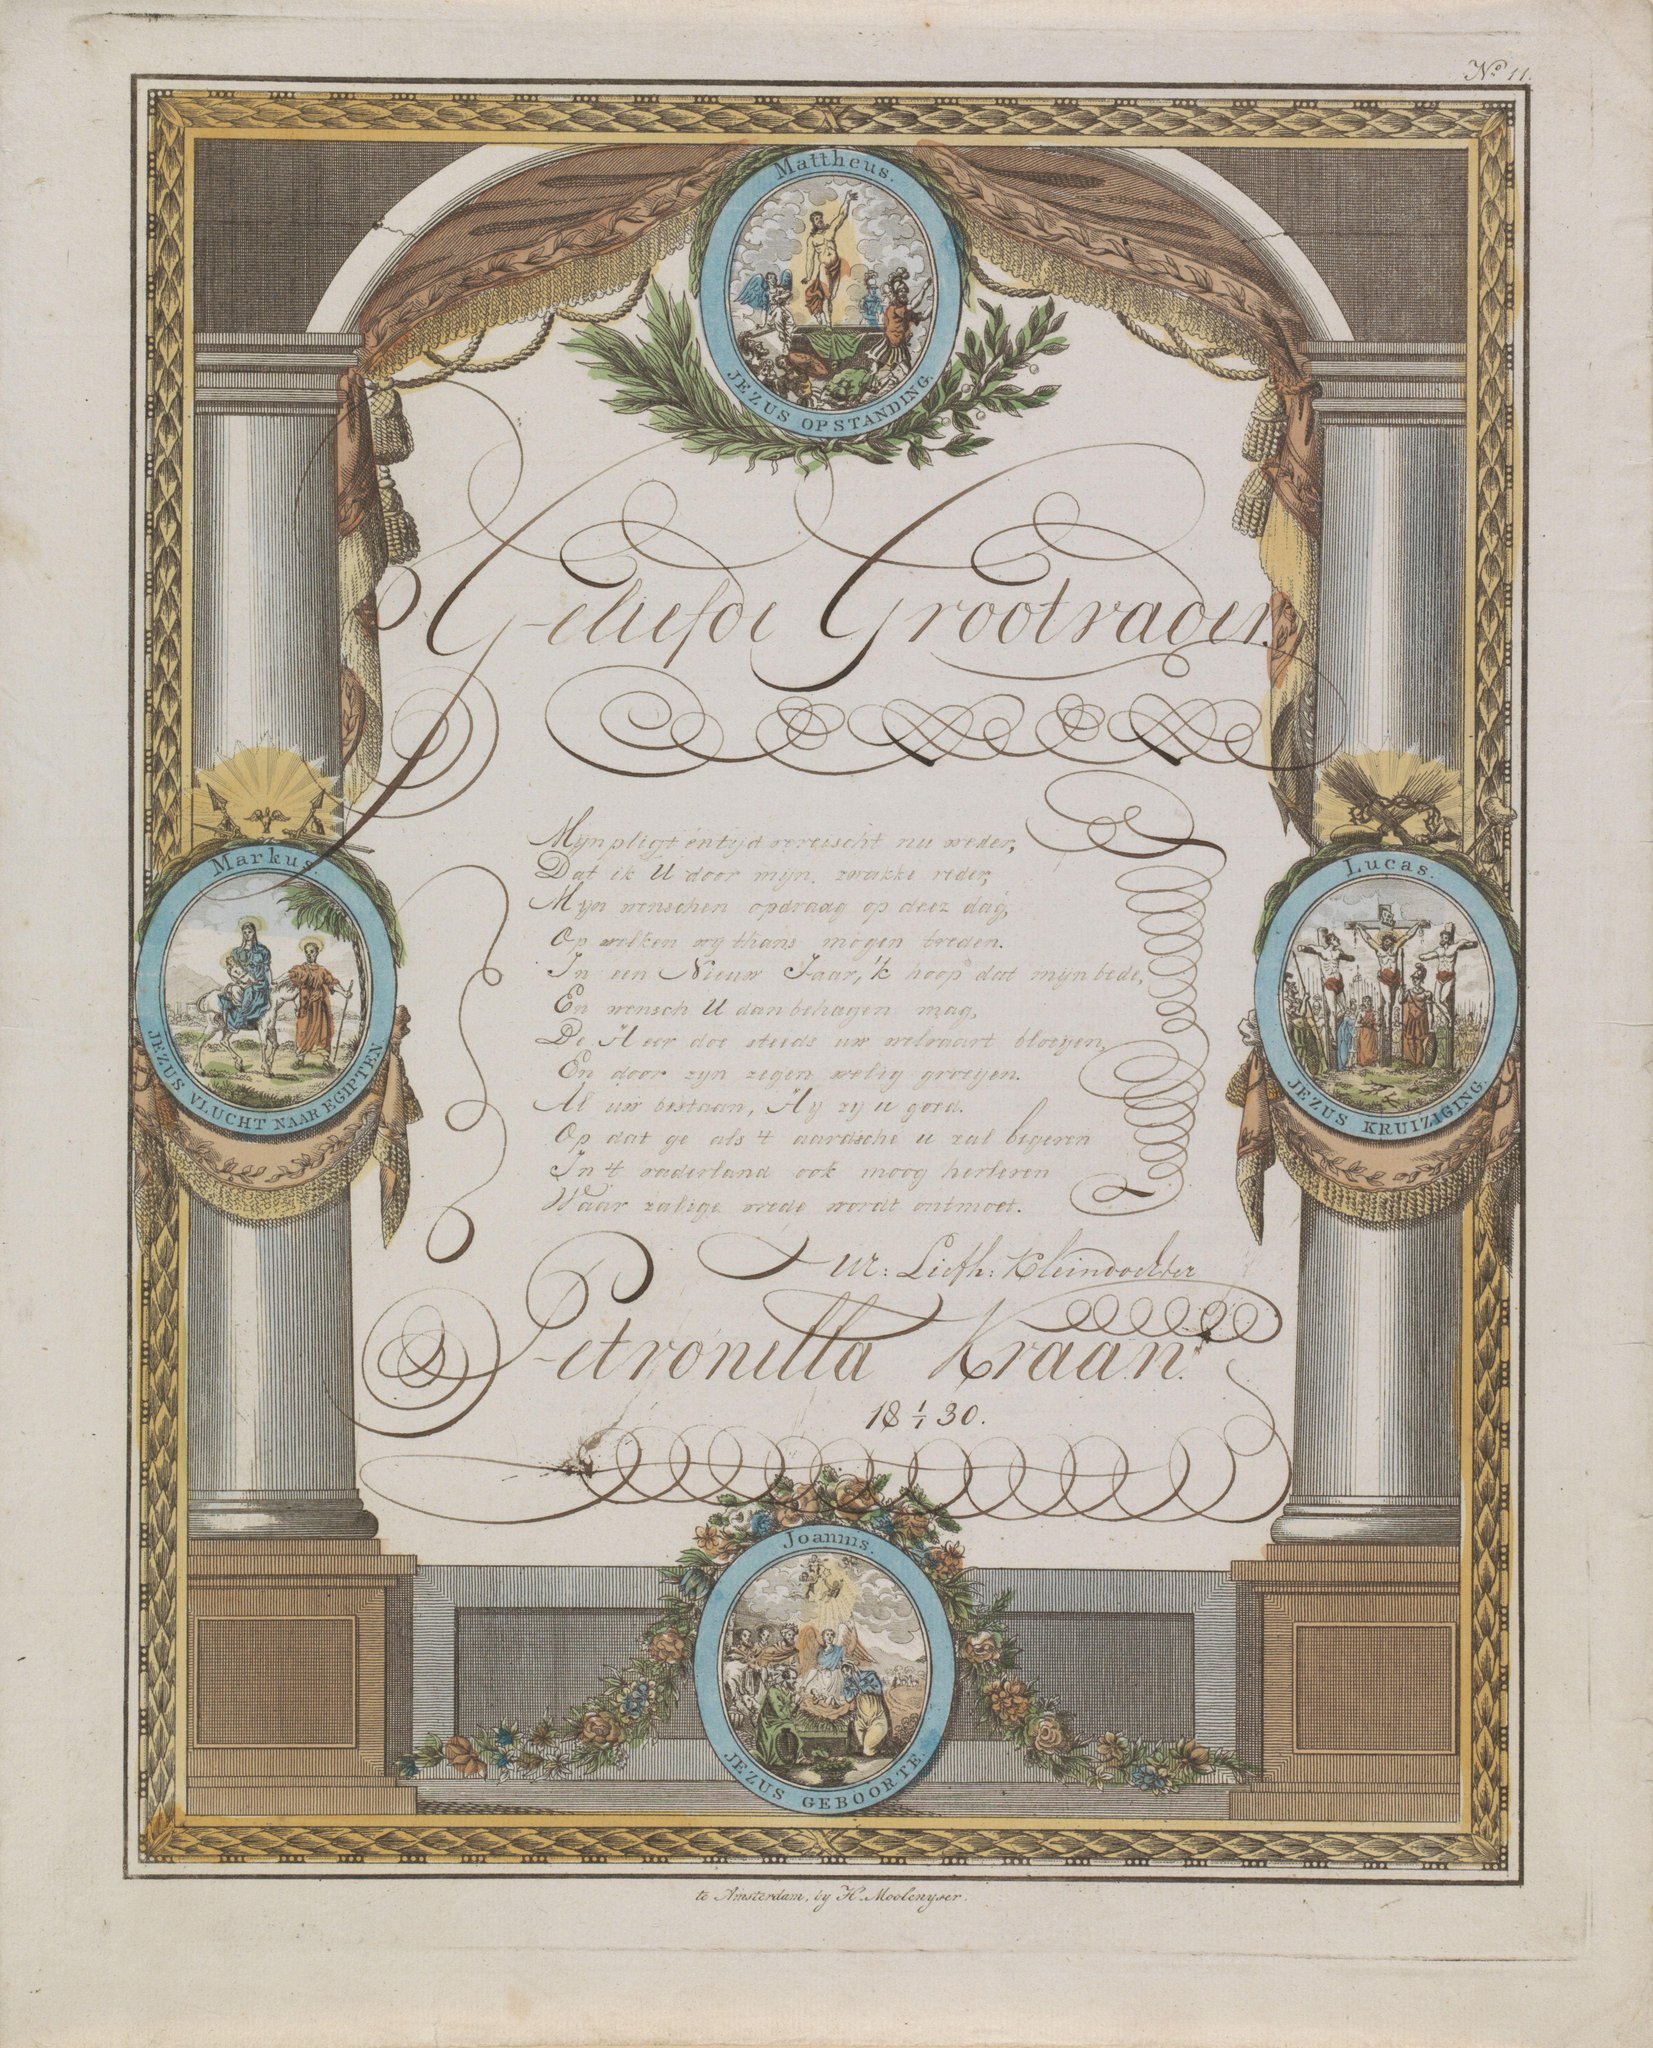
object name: wensbrief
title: Wensbrief met voorstellingen uit het Nieuwe Testament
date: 1792-1847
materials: ink, paper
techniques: calligraphy, colour, etching, pen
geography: amsterdam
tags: new testament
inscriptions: inscription: ‘Geliefde grootvader. / Mijn pligt en tijd vereischt nu weder ...’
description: Wensbrief met beschreven cartouche binnen een decoratief kader met voorstellingen voorstellingen uit het Nieuwe Testament. Handgeschreven bericht in kalligrafie door Petronella Kraan aan haar grootvader. Genummerd rechtsboven: No. 11.